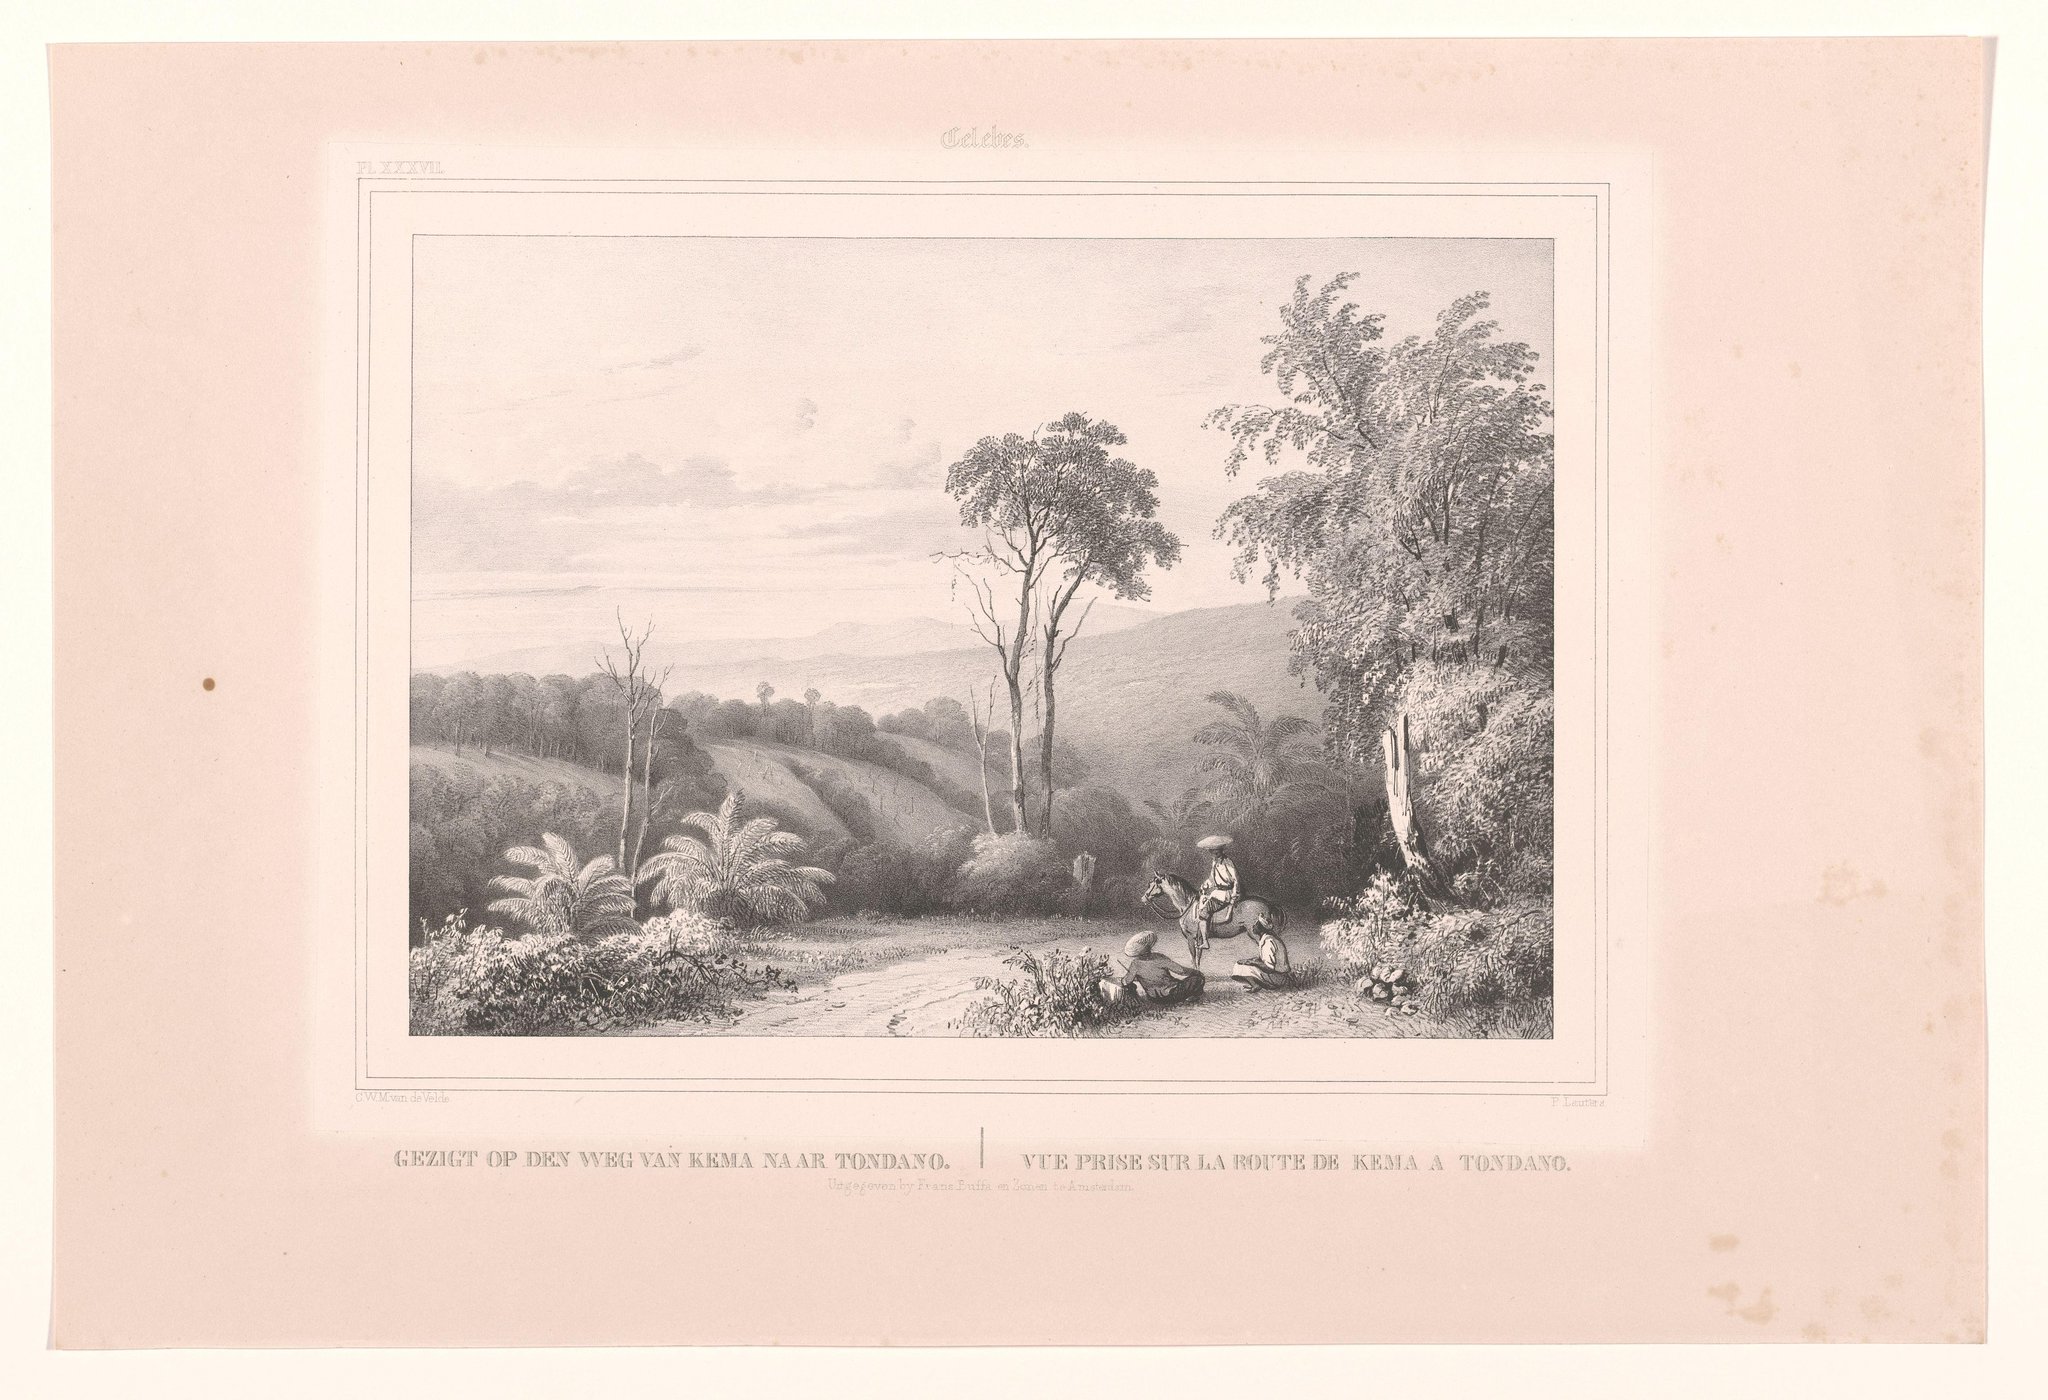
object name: print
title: Gezicht op een glooiend landschap met landweg in Indonesië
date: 1843-1845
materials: paper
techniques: lithograph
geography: brussels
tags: tondano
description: Aan de kant drie mannen, onder wie een te paard. Genummerd linksboven: Pl. XXXVII. De prent maakt deel uit van een omslag met acht bladen.